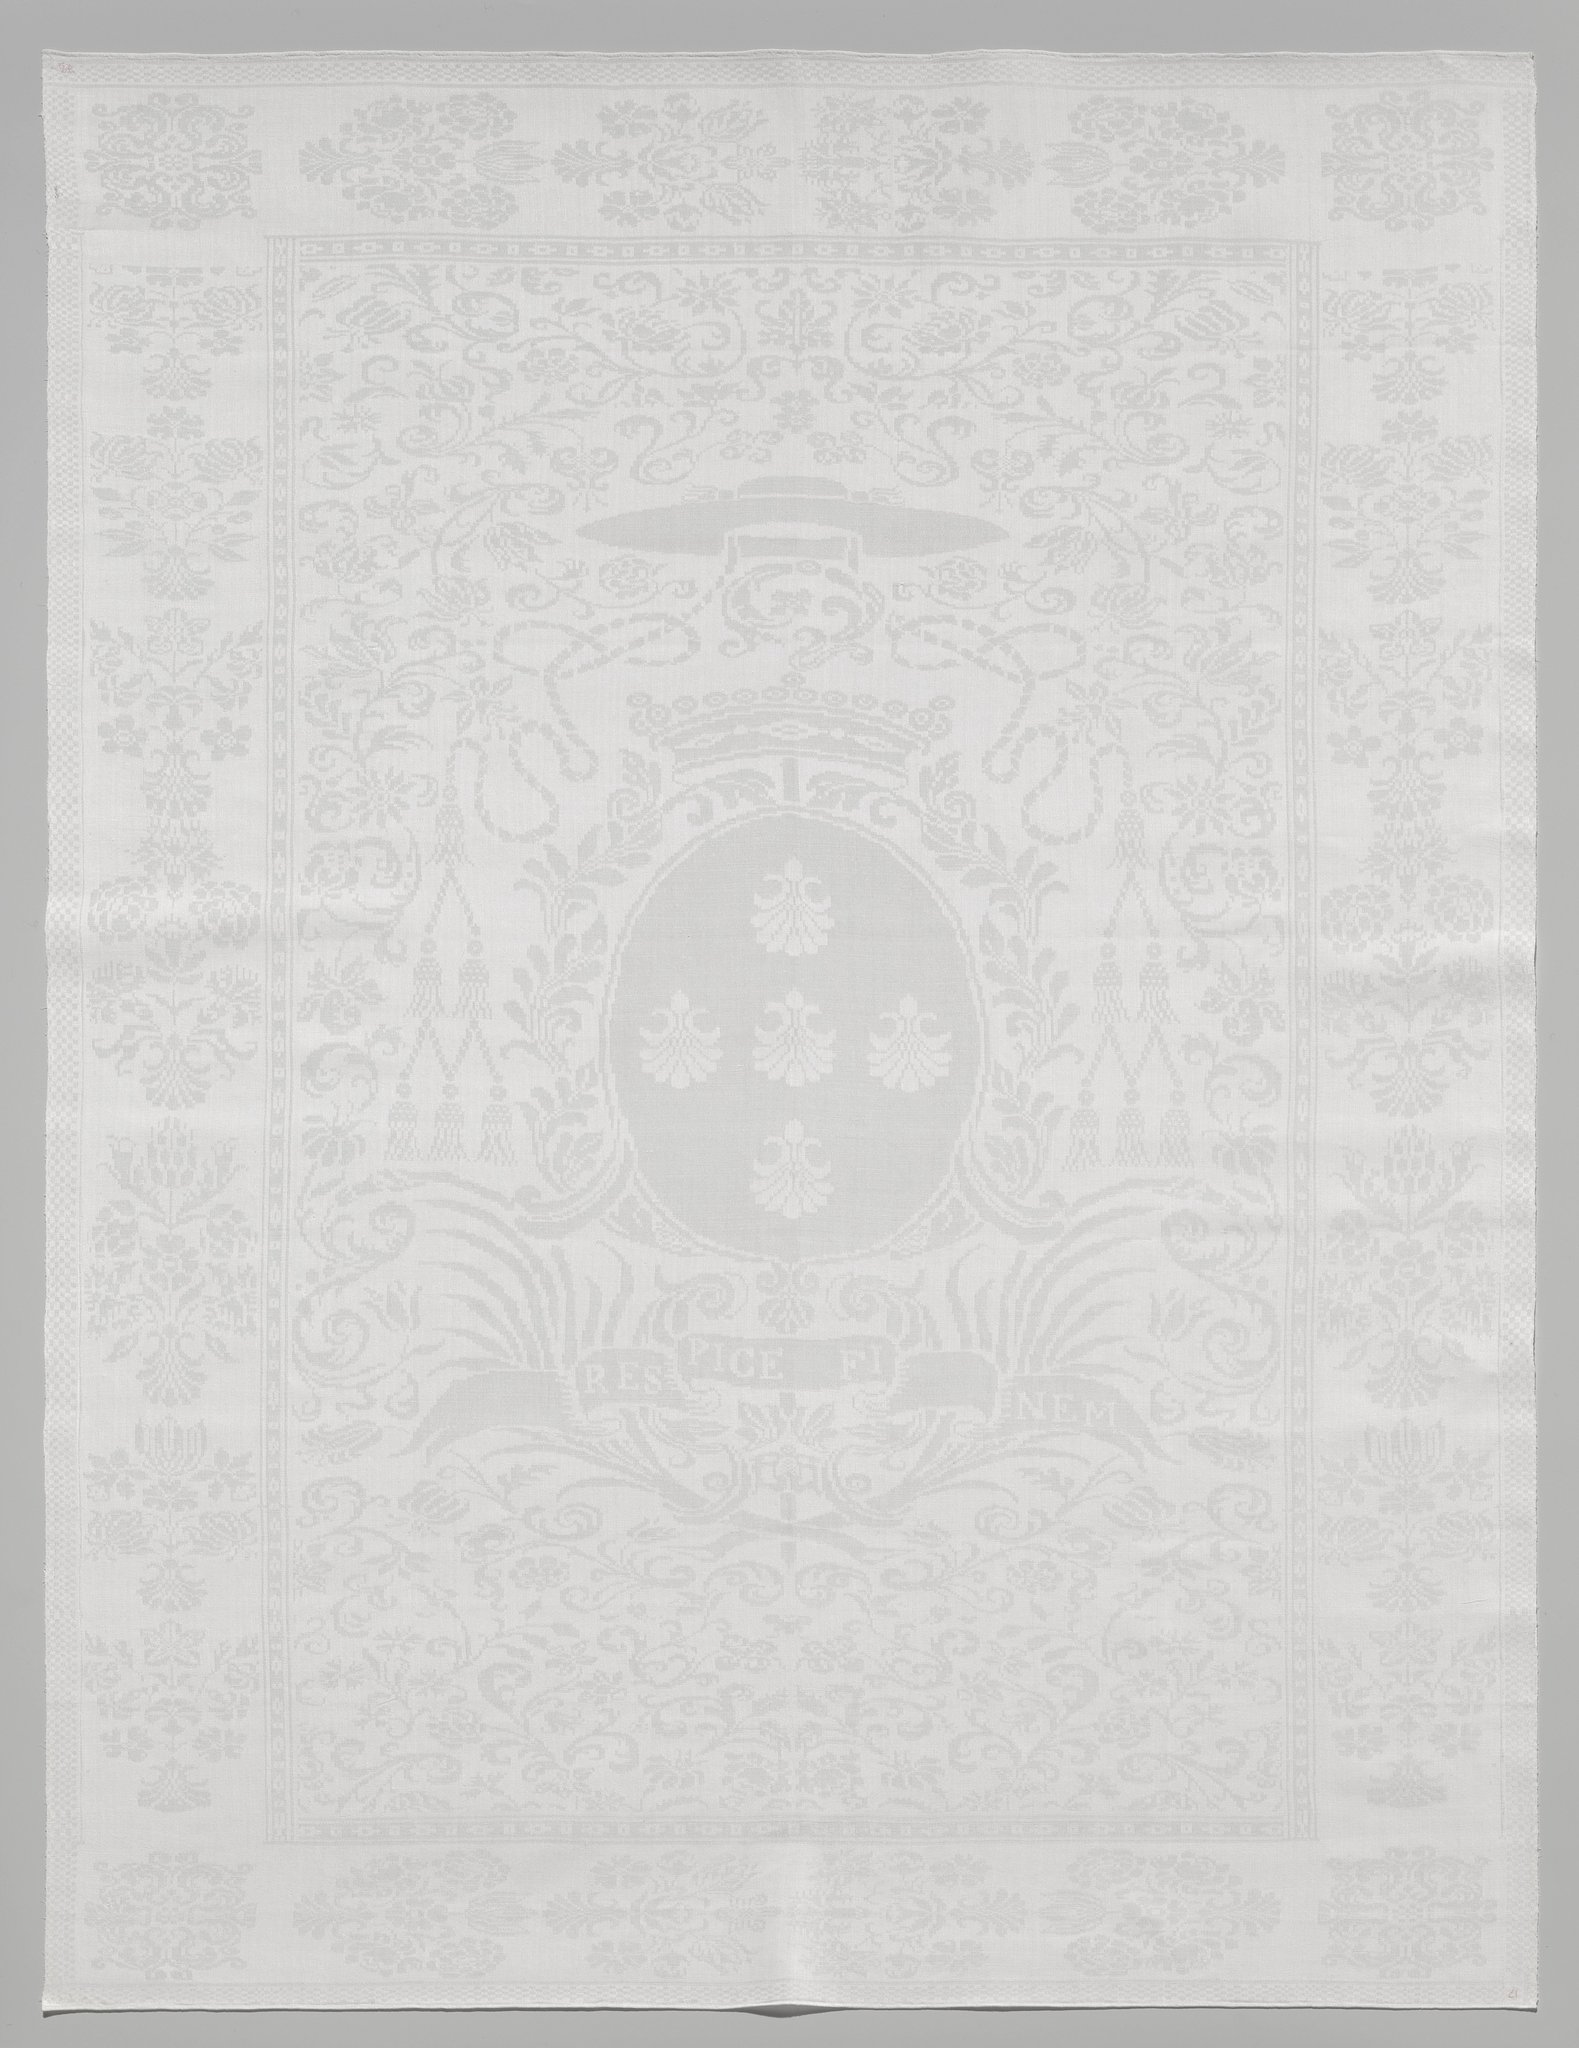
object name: napkin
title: Servet van linnendamast met wapen van P.E. van der Noot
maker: Anonymous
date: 1700-1710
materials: linen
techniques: damask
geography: flanders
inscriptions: mark: ‘VR’, mark: ‘17’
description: Servet van linnendamast met het wapen van P.E. van der Noot. Het servet hoort bij drie servetten (BK-1977-290-A t/m BK-1977-290-D) en een tafellaken (BK-1977-289). Satijn 7 binding.